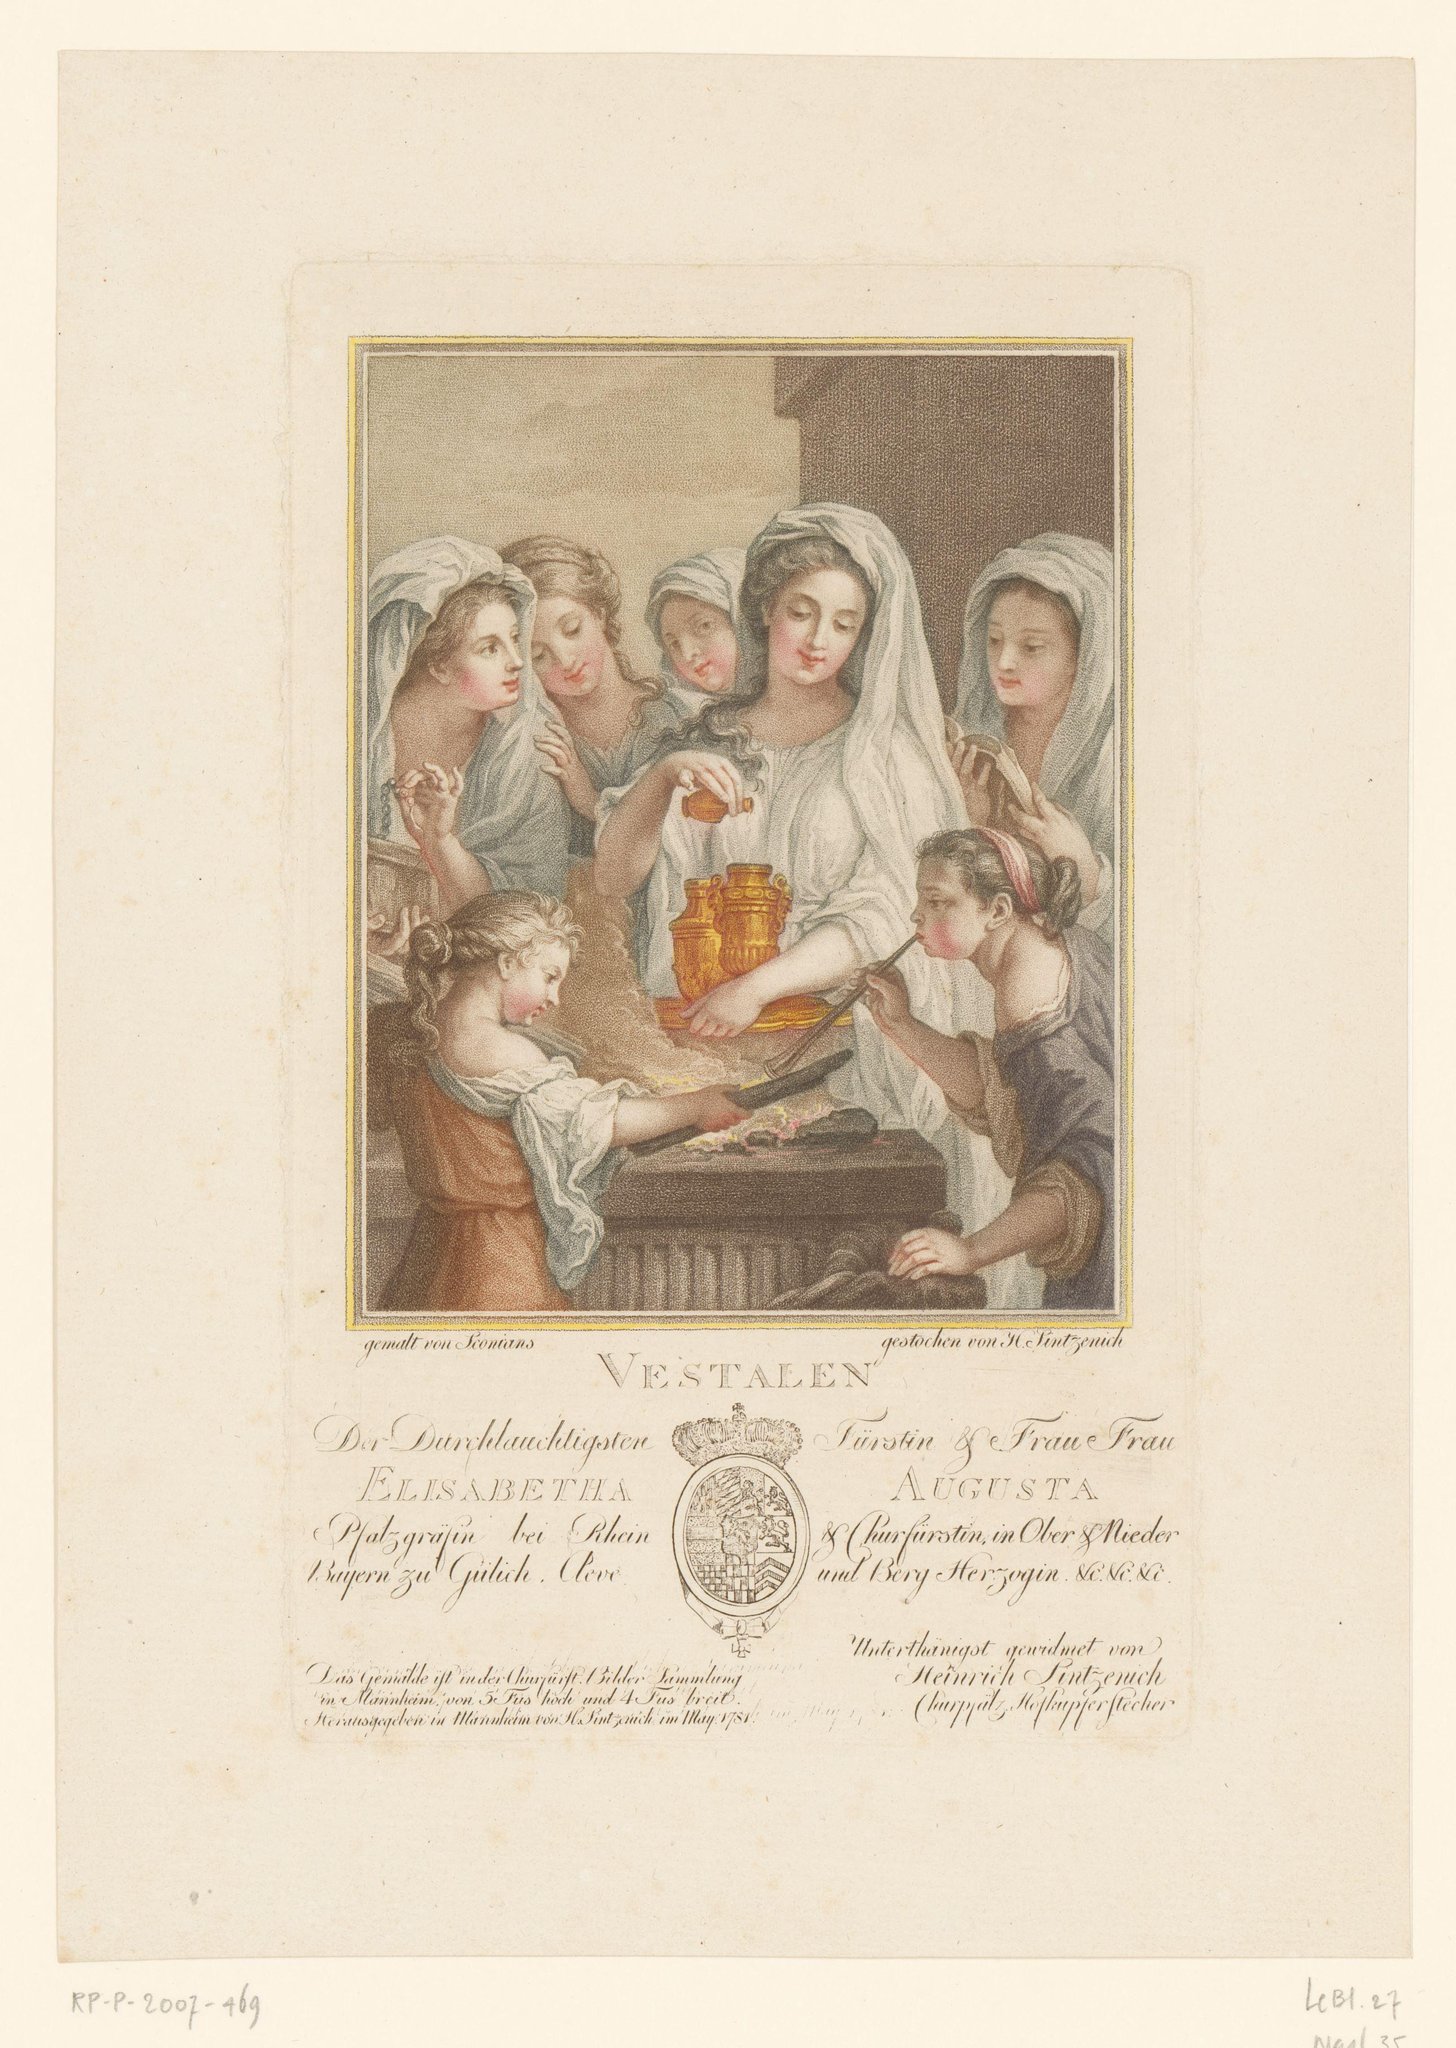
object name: print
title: De Vestaalse Maagden offerend bij een altaar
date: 1781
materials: paper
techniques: engraving, lithography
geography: mannheim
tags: vestal virgin(s)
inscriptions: date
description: Vijf vrouwen en twee meisjes rond een altaar waarop vuur brandt. De meisjes verzorgen het vuur. Een van de vrouwen draagt een blad met gouden bokalen en schenkt daar iets in. Onder de prent Duitse tekst: de titel, de opdracht aan Elisabetha Ausguta, haar wapen en een beschrijving van het schilderij van Schoonjans in de verzameling van de Keurvorst.